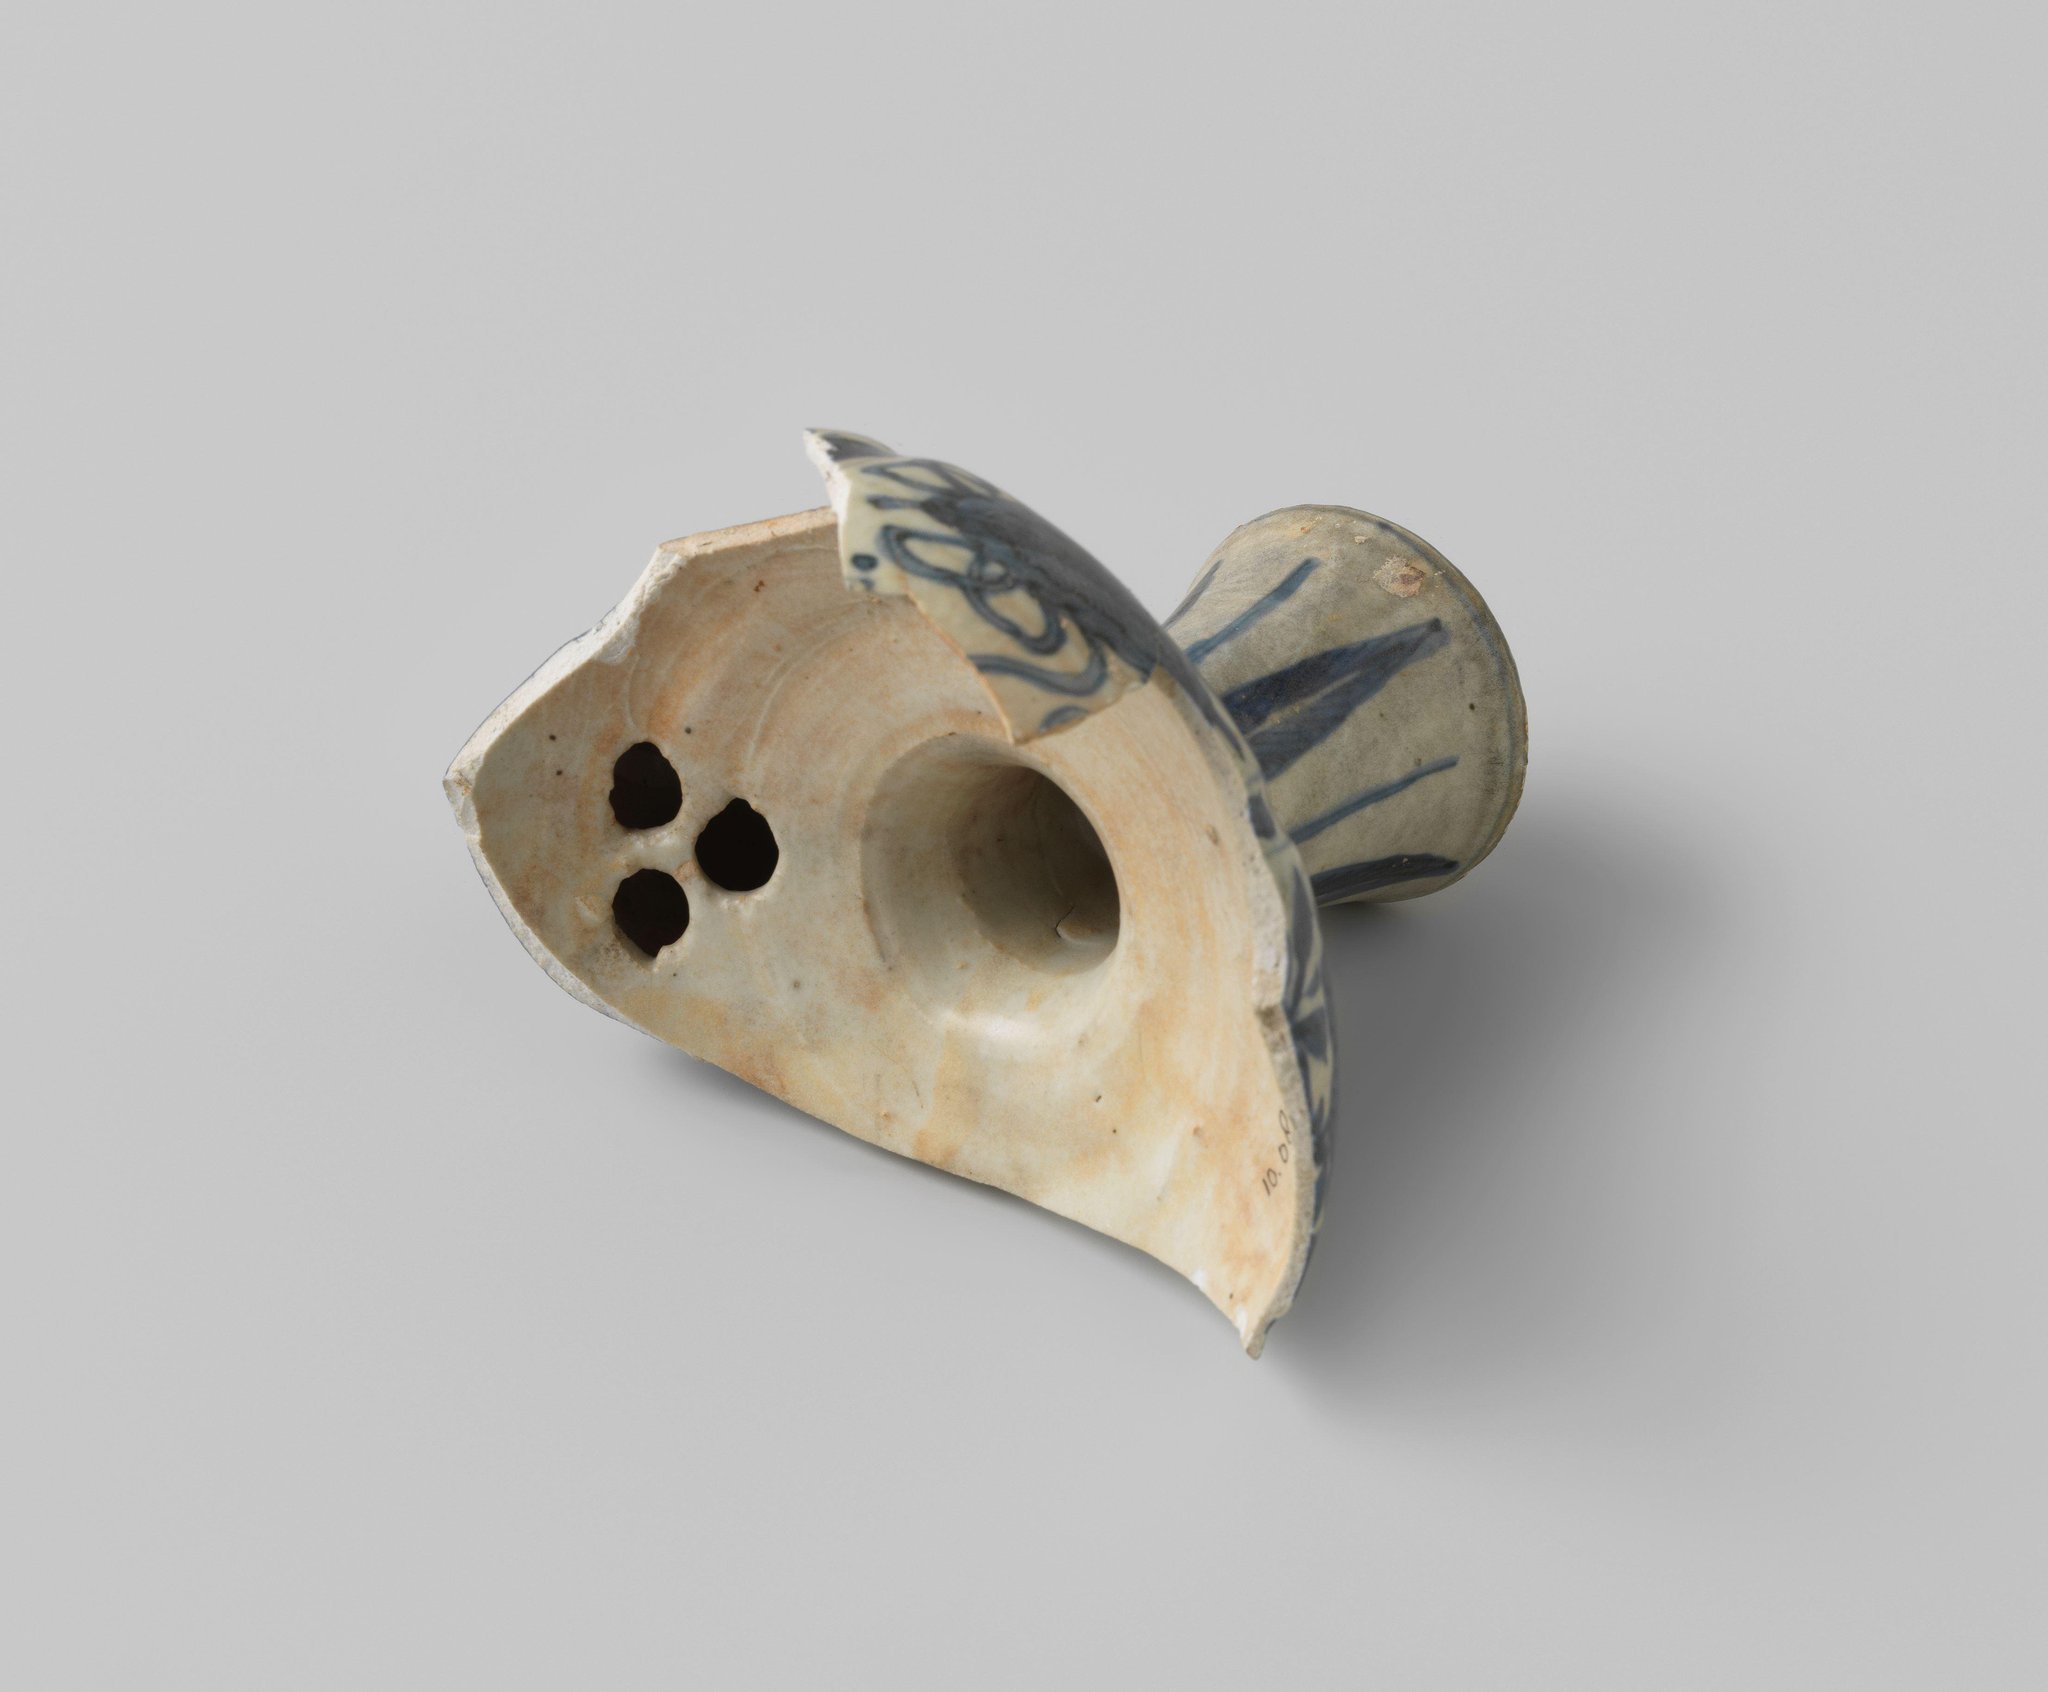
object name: sherd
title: Fragment wijnkan uit V.O.C.-schip de 'Witte Leeuw'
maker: Anonymous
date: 1613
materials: bone china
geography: jingdezhen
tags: verenigde oostindische compagnie, sint-helena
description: A kendi with a rounded side. Decorated with birds and flowers under a band with diaper patterns. The neck decorated with plantain leaves, the spout with peaches and groups of dots in sections.